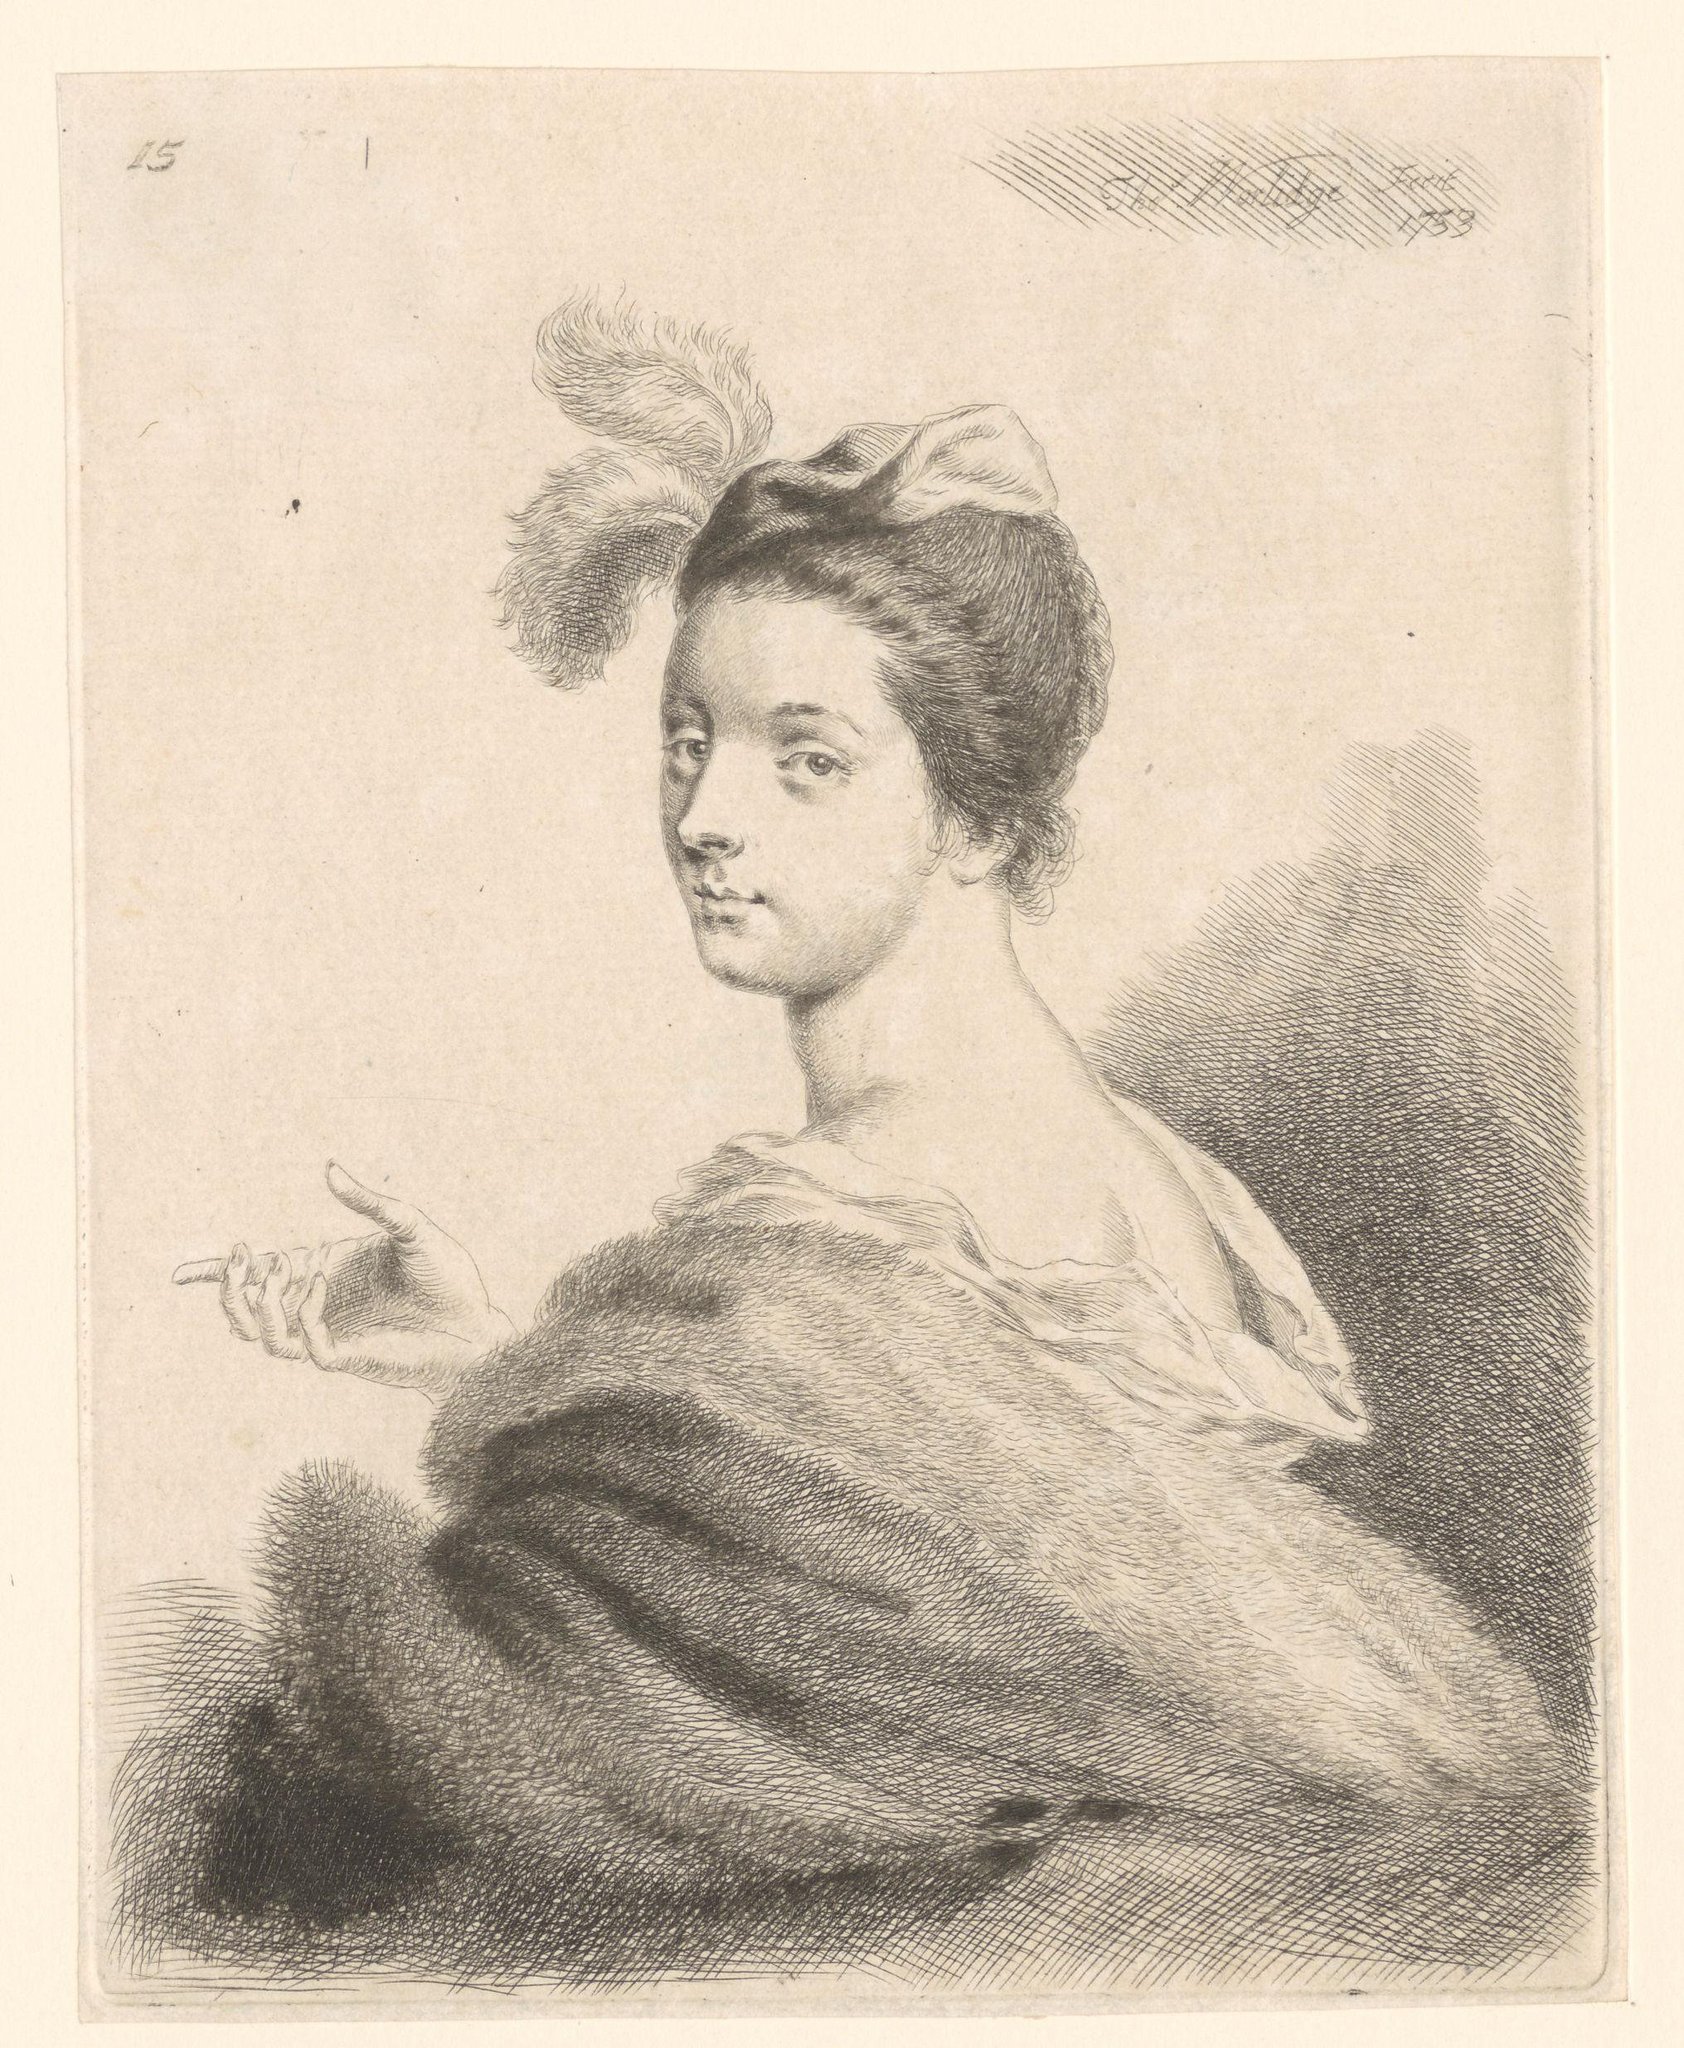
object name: print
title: Portret van een onbekende vrouw met veer in het haar en cape met bont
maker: thomas worlidge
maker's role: print maker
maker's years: 1700-1766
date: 1753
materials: paper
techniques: drypoint, etching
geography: london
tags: head-gear (with name) (+ women's clothes), cape, anonymous historical person portrayed alone - bb - woman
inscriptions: collector's mark: Lugt 2760, collector's mark: Lugt 2228